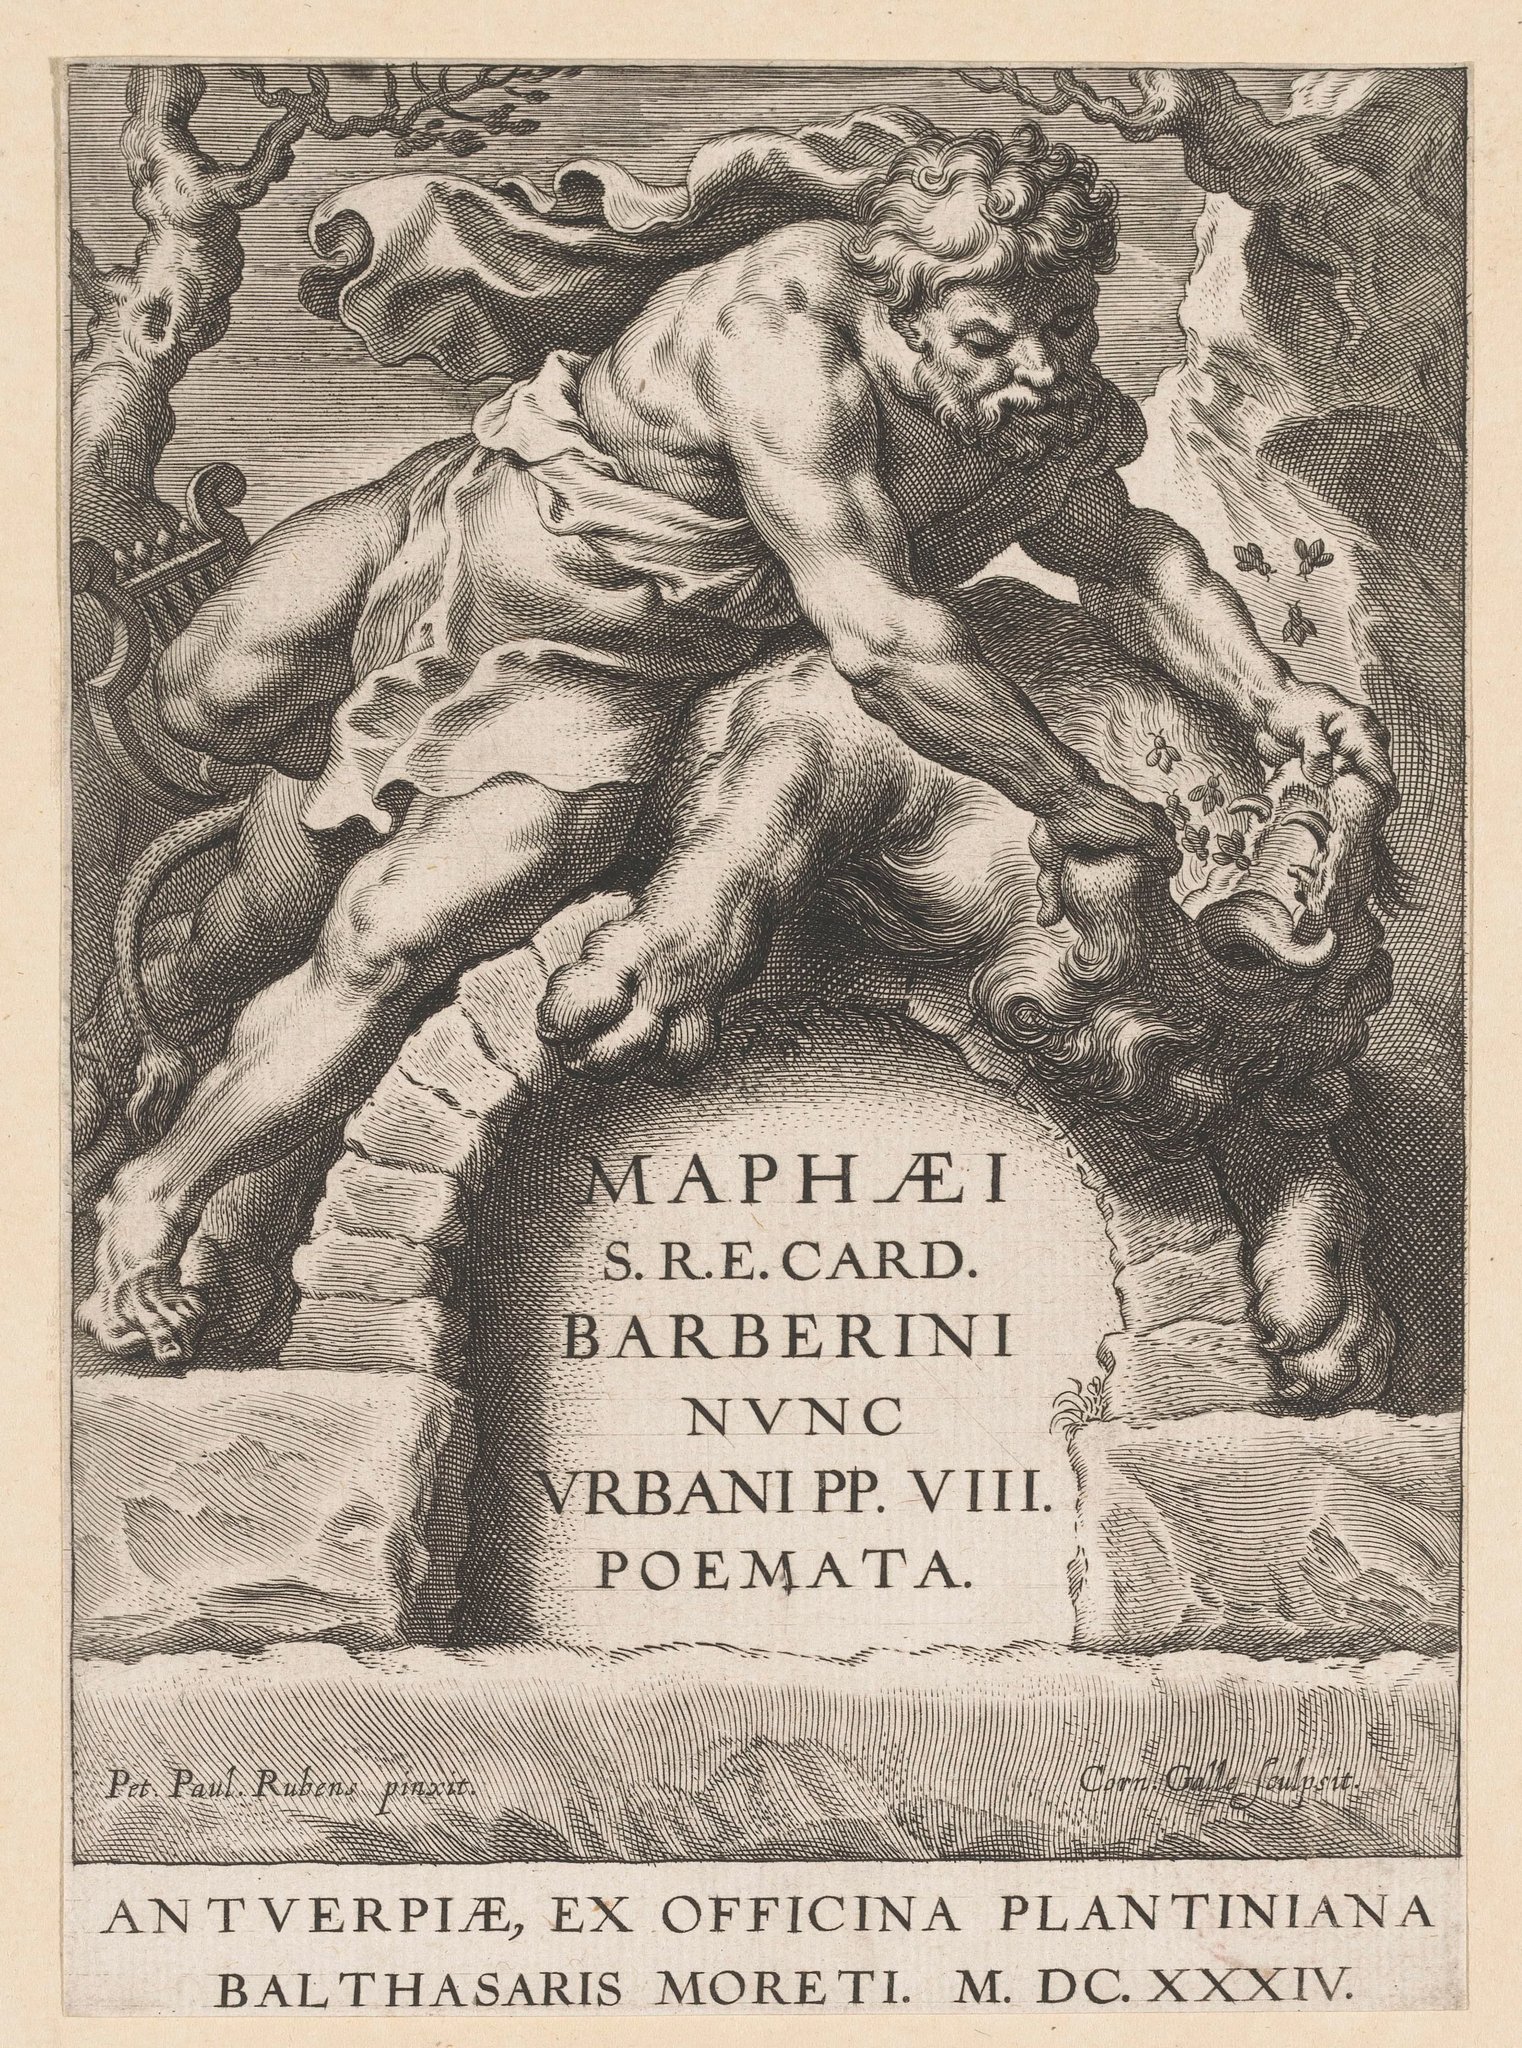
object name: print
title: Titelpagina voor: M. Barberini, Poemata, Antwerpen: 1634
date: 1634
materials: paper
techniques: engraving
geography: southern netherlands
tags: samson finds a swarm of bees in the lion's body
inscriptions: collector's mark: Lugt 240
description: In een rotsachtig landschap trekt Simson met zijn handen de kaken van de leeuw uiteen. Een zwerm bijen vliegt rond de bek van het dier. Onder een stenen boog de titel van het boek.